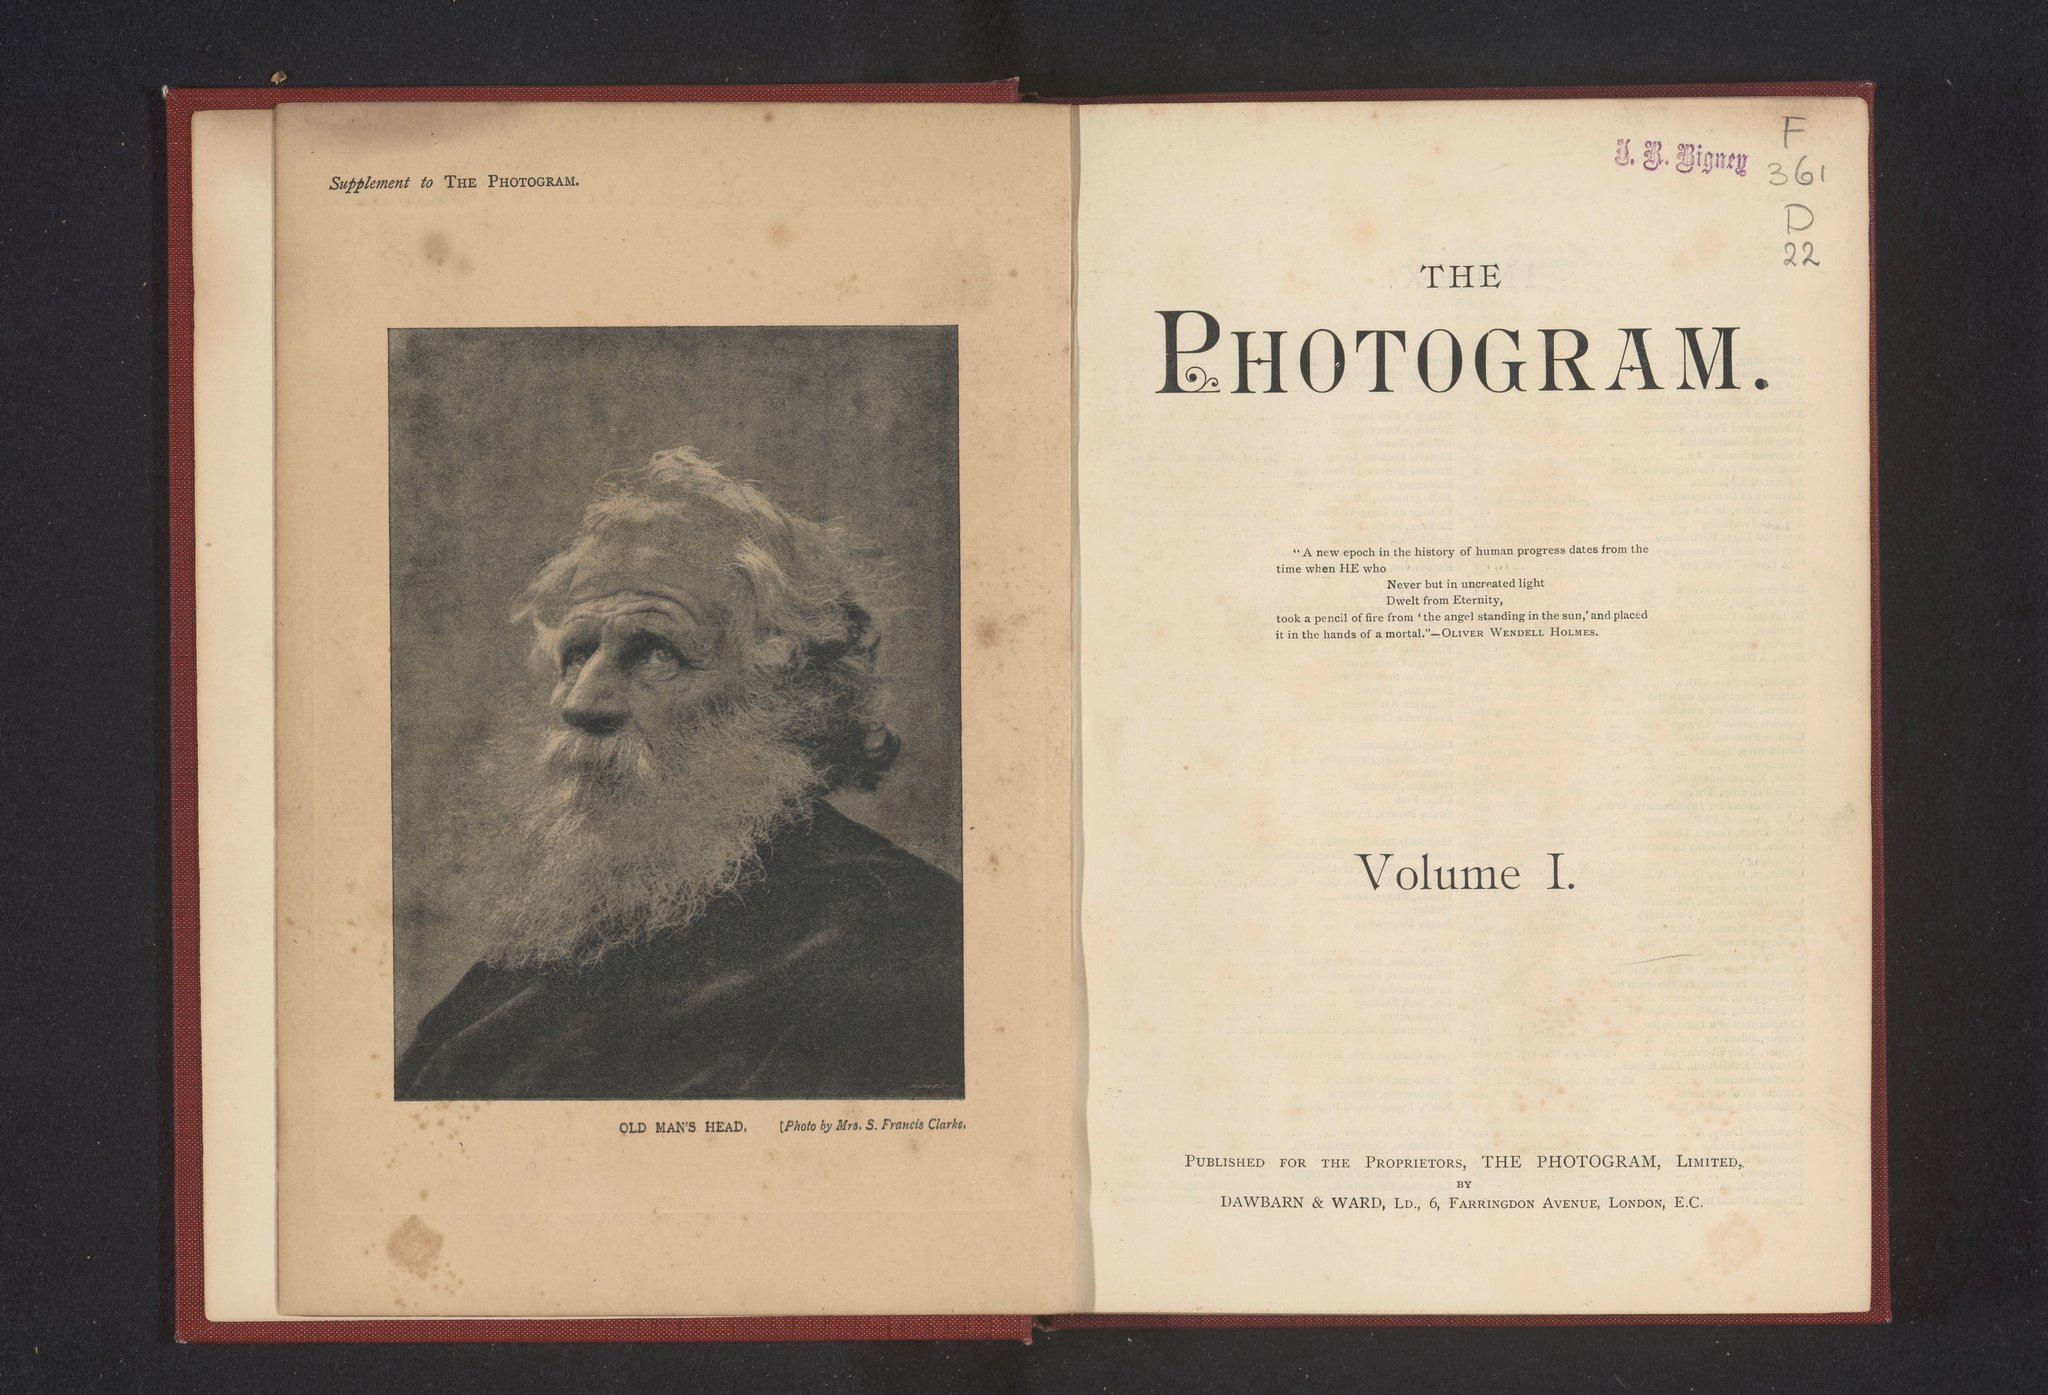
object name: page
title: Old man's head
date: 1889-1894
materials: paper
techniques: autotype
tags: historical persons